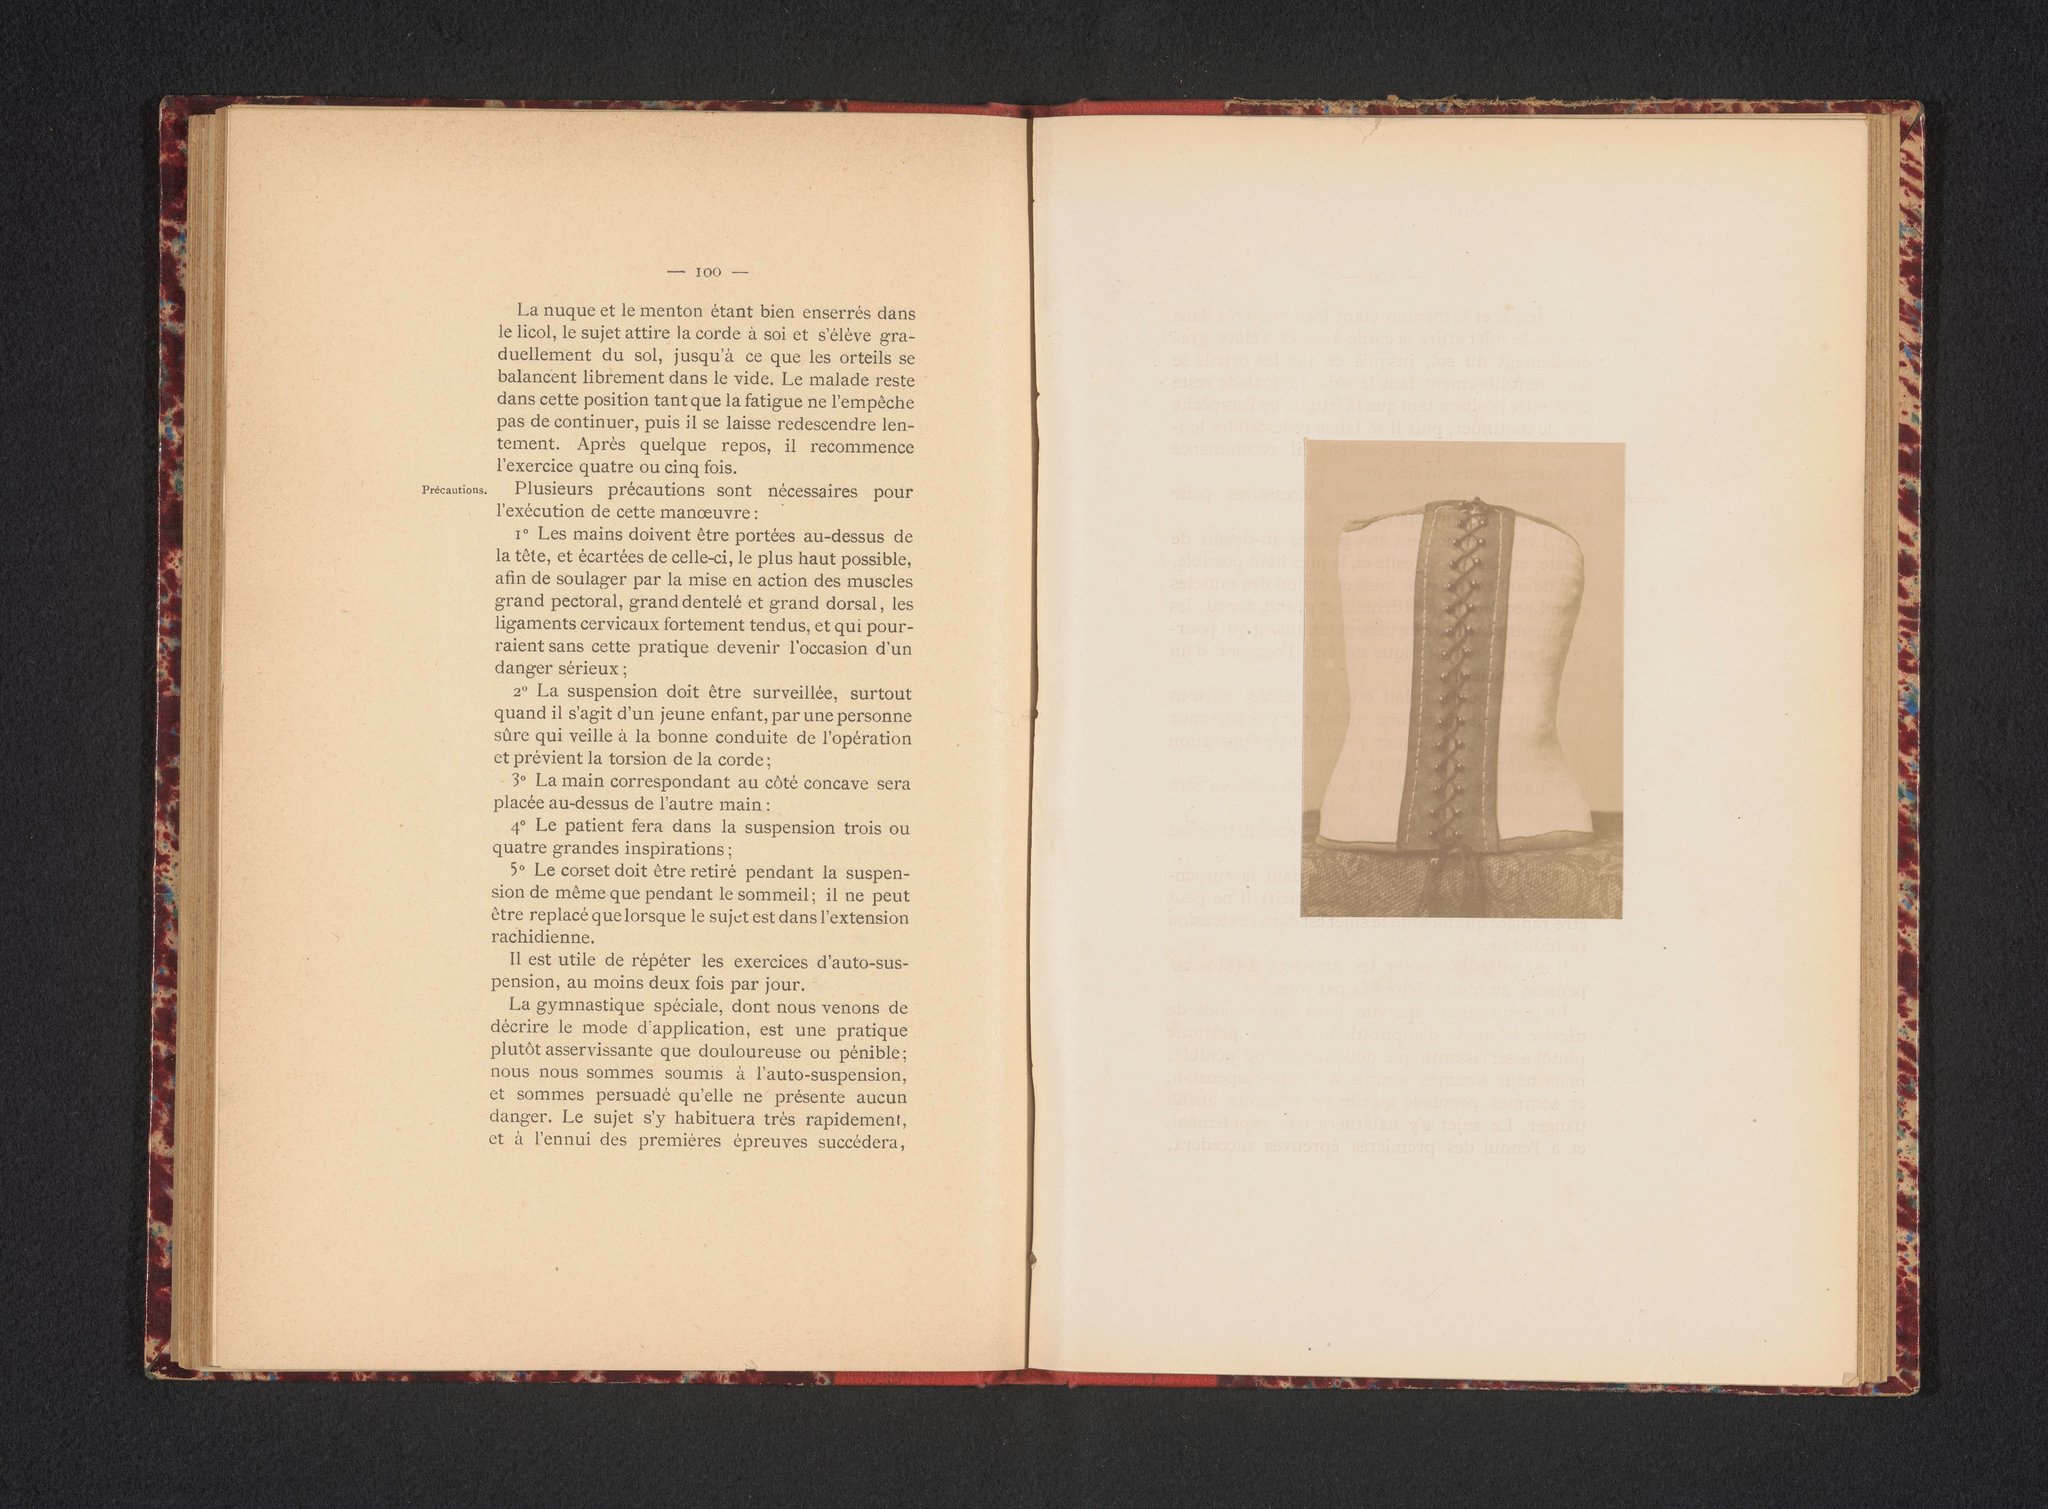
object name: photograph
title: Korset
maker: Anonymous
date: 1884-1889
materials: photographic support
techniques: albumen print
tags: underclothes for the upper part of the body: corset